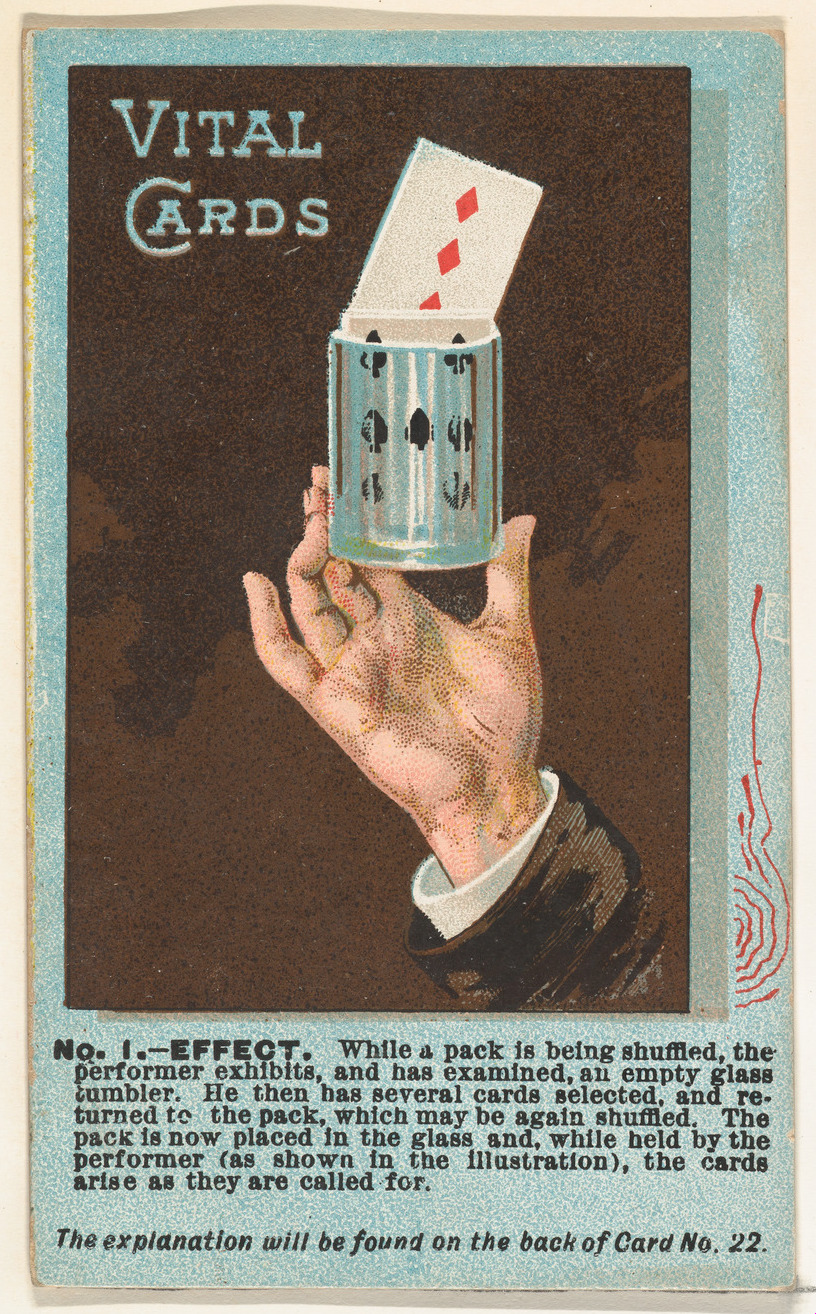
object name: print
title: Number 1, Vital Cards, from the Tricks with Cards series (N138) issued by W. Duke, Sons & Co. to promote Honest Long Cut Tobacco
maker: w. duke, sons & co.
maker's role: publisher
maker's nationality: american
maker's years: 1870-1920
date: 1887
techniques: color lithograph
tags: hands,magic,playing cards